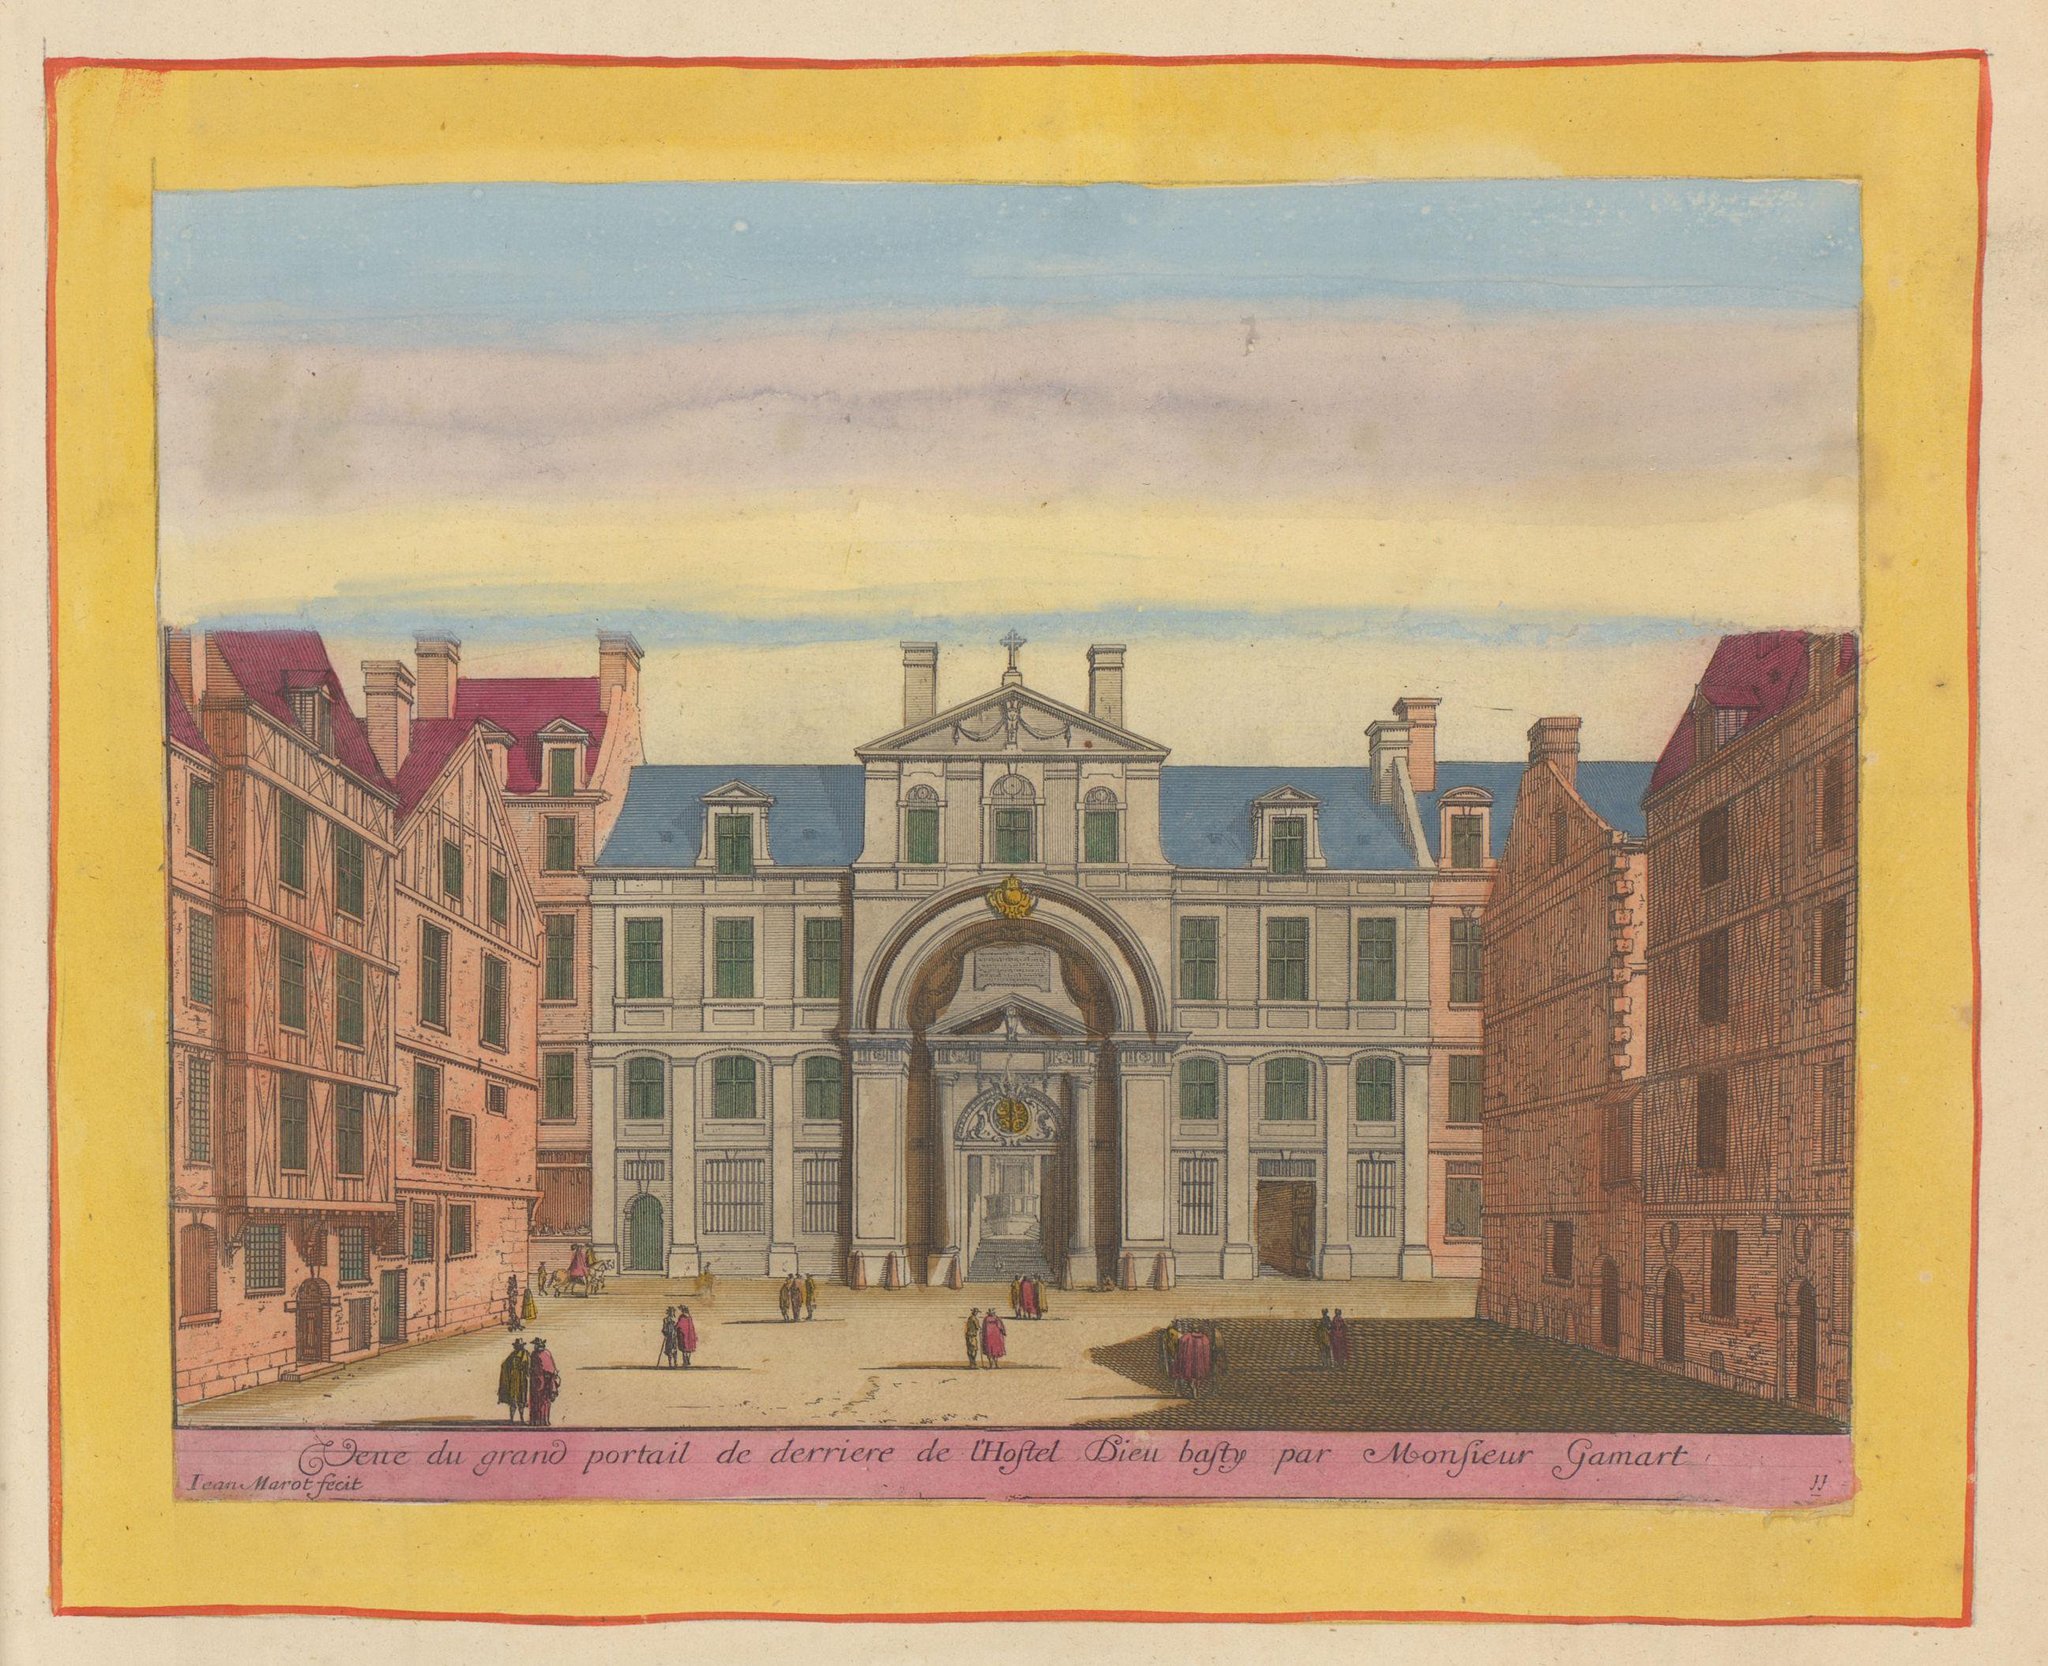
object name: album leaf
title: Kerken te Parijs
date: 1655-1679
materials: paper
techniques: etching, hand coloring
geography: paris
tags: hospital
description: Gezicht op de grote toegangspoort van het armenhuis en ziekenhuis Hôtel-Dieu te Parijs. Prent maakt deel uit van een album.